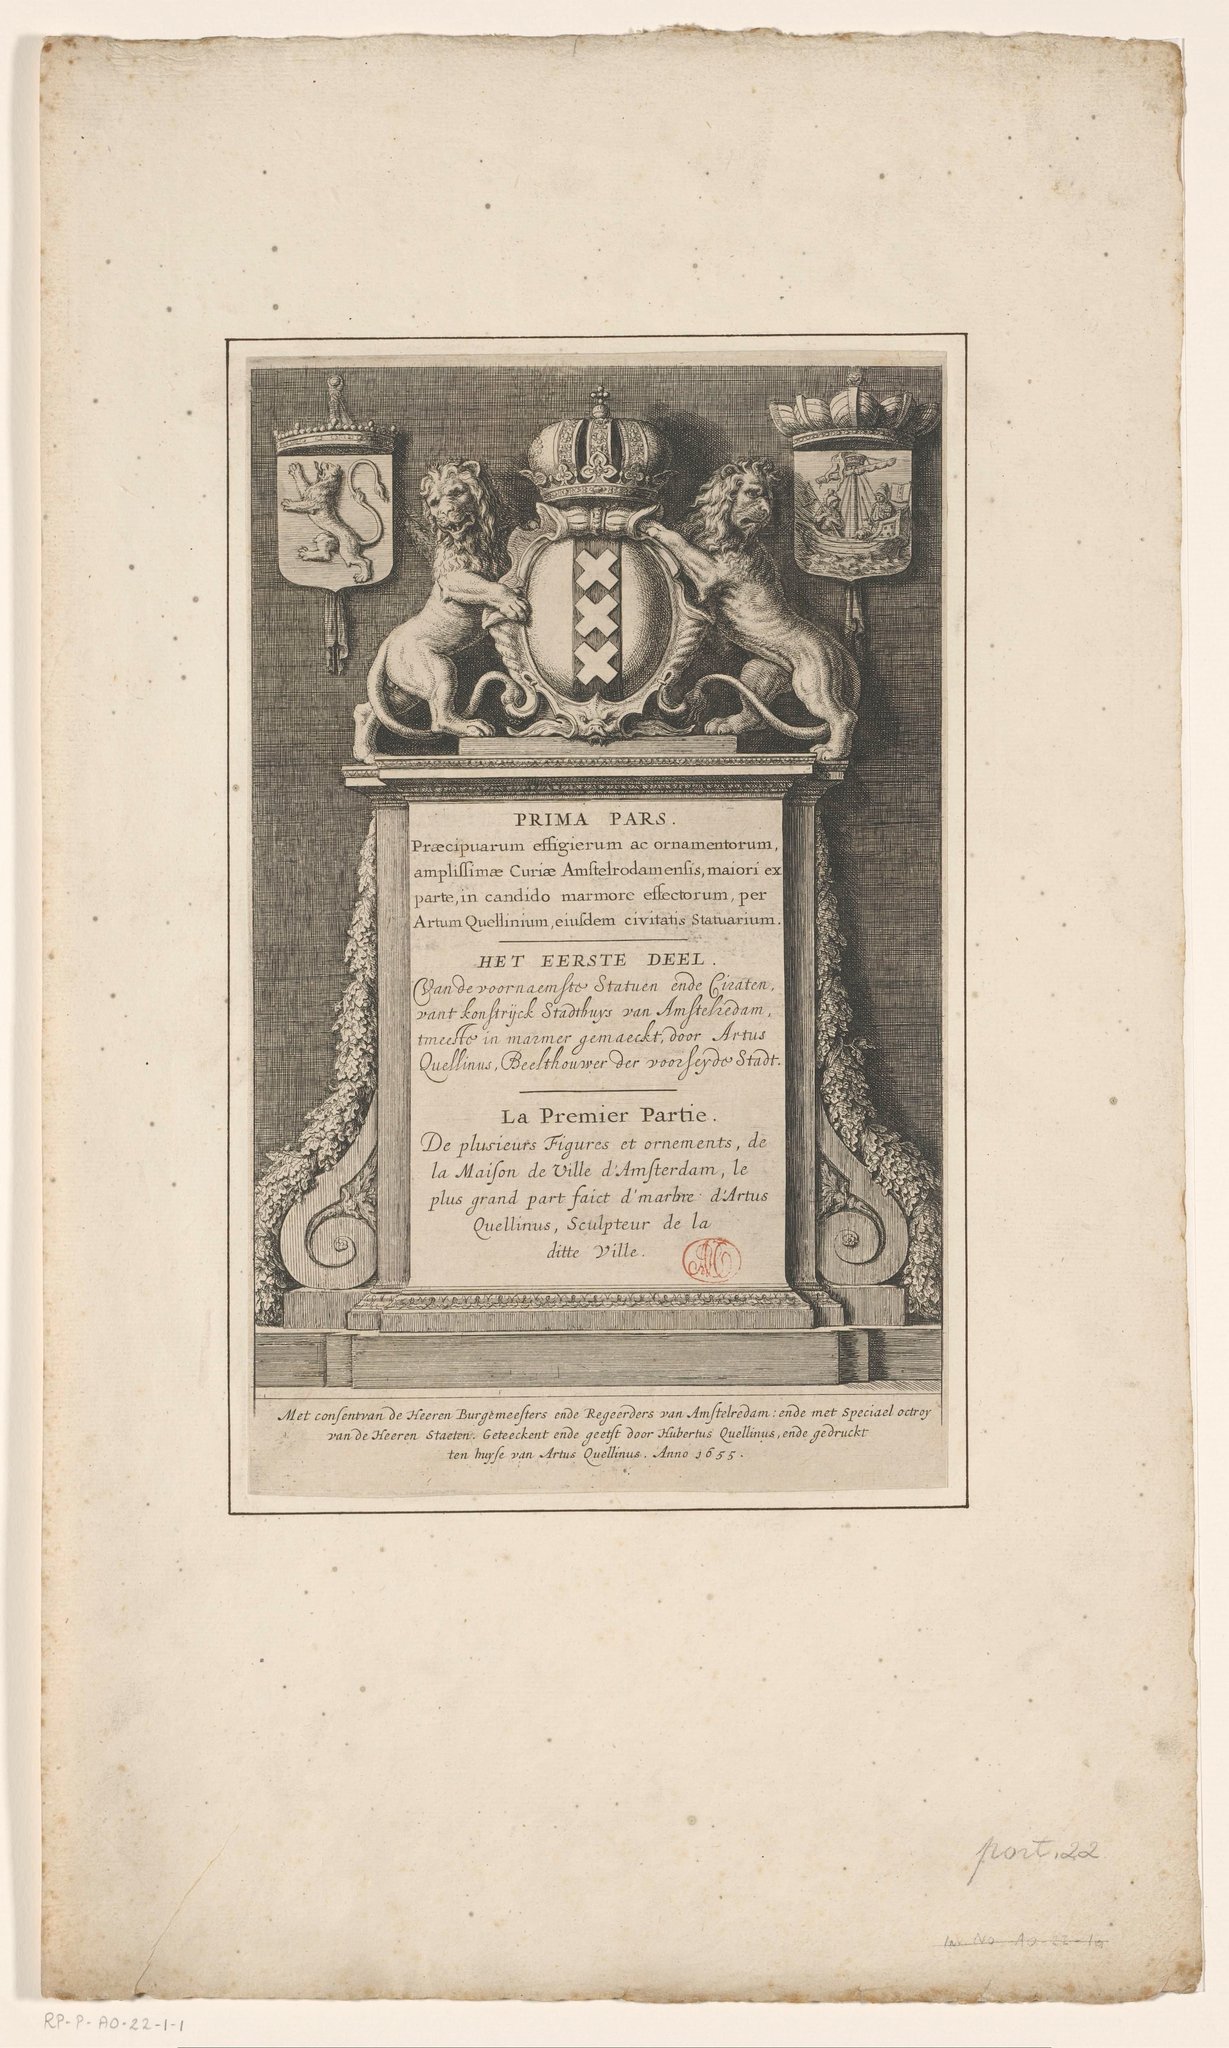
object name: titelblad, titelpagina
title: Sokkel met het wapen van Amsterdam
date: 1655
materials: paper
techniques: engraving, etching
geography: amsterdam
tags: coat of arms (as symbol of the state, etc.) (+ city; municipal), seal (as symbol of the state, etc.) (+ city; municipal), title-page, coat of arms (as symbol of the state, etc.) (+ province; provincial)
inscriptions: collector's mark: Lugt 195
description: Prent gebruikt in: Prima pars. Praecipuarum effigierum ac ornamentorum, amplissimae Curiae Amstelrodamensis (…) / Het eerste deel. Van de voornaemste Statuen ende Ciraten, vant konstijck Stadhuys van Amstelredam, tmeeste in marmer gemaeckt, door Artus Quellinus, Beelthouwer der voorseyde Stadt / La Premier Partie. De plusieurs Figures et ornements, de la Maison de Ville d'Amsterdam (…). Amsterdam: Artus Quellinus (I), 1655. Zie RP-P-AO-22-1-2 voor bijhorend register. Zie RP-P-AO-22-1A, RP-P-AO-22-1B, RP-P-AO-22-1C, RP-P-AO-22-1D-1, RP-P-AO-22-1D-2, RP-P-AO-22-1E, RP-P-AO-22-1F, RP-P-AO-22-1G, RP-P-AO-22-1H, RP-P-AO-22-1I, RP-P-AO-22-1K-1, RP-P-AO-22-1K-2, RP-P-AO-22-1K-3, RP-P-AO-22-1K-4, RP-P-AO-22-1K-5, RP-P-AO-22-1L-1, RP-P-AO-22-1L-2, RP-P-AO-22-1M-1, RP-P-AO-22-1M-2, RP-P-AO-22-1N-1, RP-P-AO-22-1N-2, RP-P-AO-22-1N-3, RP-P-AO-22-1N-4, RP-P-AO-22-1N-5, RP-P-AO-22-1O-1, RP-P-AO-22-1O-2, RP-P-AO-22-1O-3, RP-P-AO-22-1O-4, RP-P-AO-22-1P-1, RP-P-AO-22-1P-2, RP-P-AO-22-1P-3, RP-P-AO-22-1P-4, RP-P-AO-22-1Q-1, RP-P-AO-22-1Q-2, RP-P-AO-22-1Q-3, RP-P-AO-22-1Q-4, RP-P-AO-22-1R-1, RP-P-AO-22-1R-2, RP-P-AO-22-1R-3, RP-P-AO-22-1R-4, RP-P-AO-22-1R-5, RP-P-AO-22-1S-1, RP-P-AO-22-1S-2, RP-P-AO-22-1S-3, RP-P-AO-22-1S-4, RP-P-AO-22-1S-5, RP-P-AO-22-1T-1 en RP-P-AO-22-1T-2 voor prenten uit deze publicatie. Latere staat van prent ook gebruikt in: Prima pars. Praecipuarum effigierum ac ornamentorum, amplissimae Curiae Amstelrodamensis (…) / Het eerste deel. Van de voornaemste Statuen ende Ciraten, vant konstijck Stadhuys van Amstelredam, tmeeste in marmer gemaeckt, door Artus Quellinus, Beelthouwer der voorseyde Stadt / La Premier Partie. De plusieurs Figures et ornements, de la Maison de Ville d'Amsterdam (…). Amsterdam: Frederik de Wit, 1665. Zie RP-P-AO-22-2-1 voor titelpagina van tweede deel.